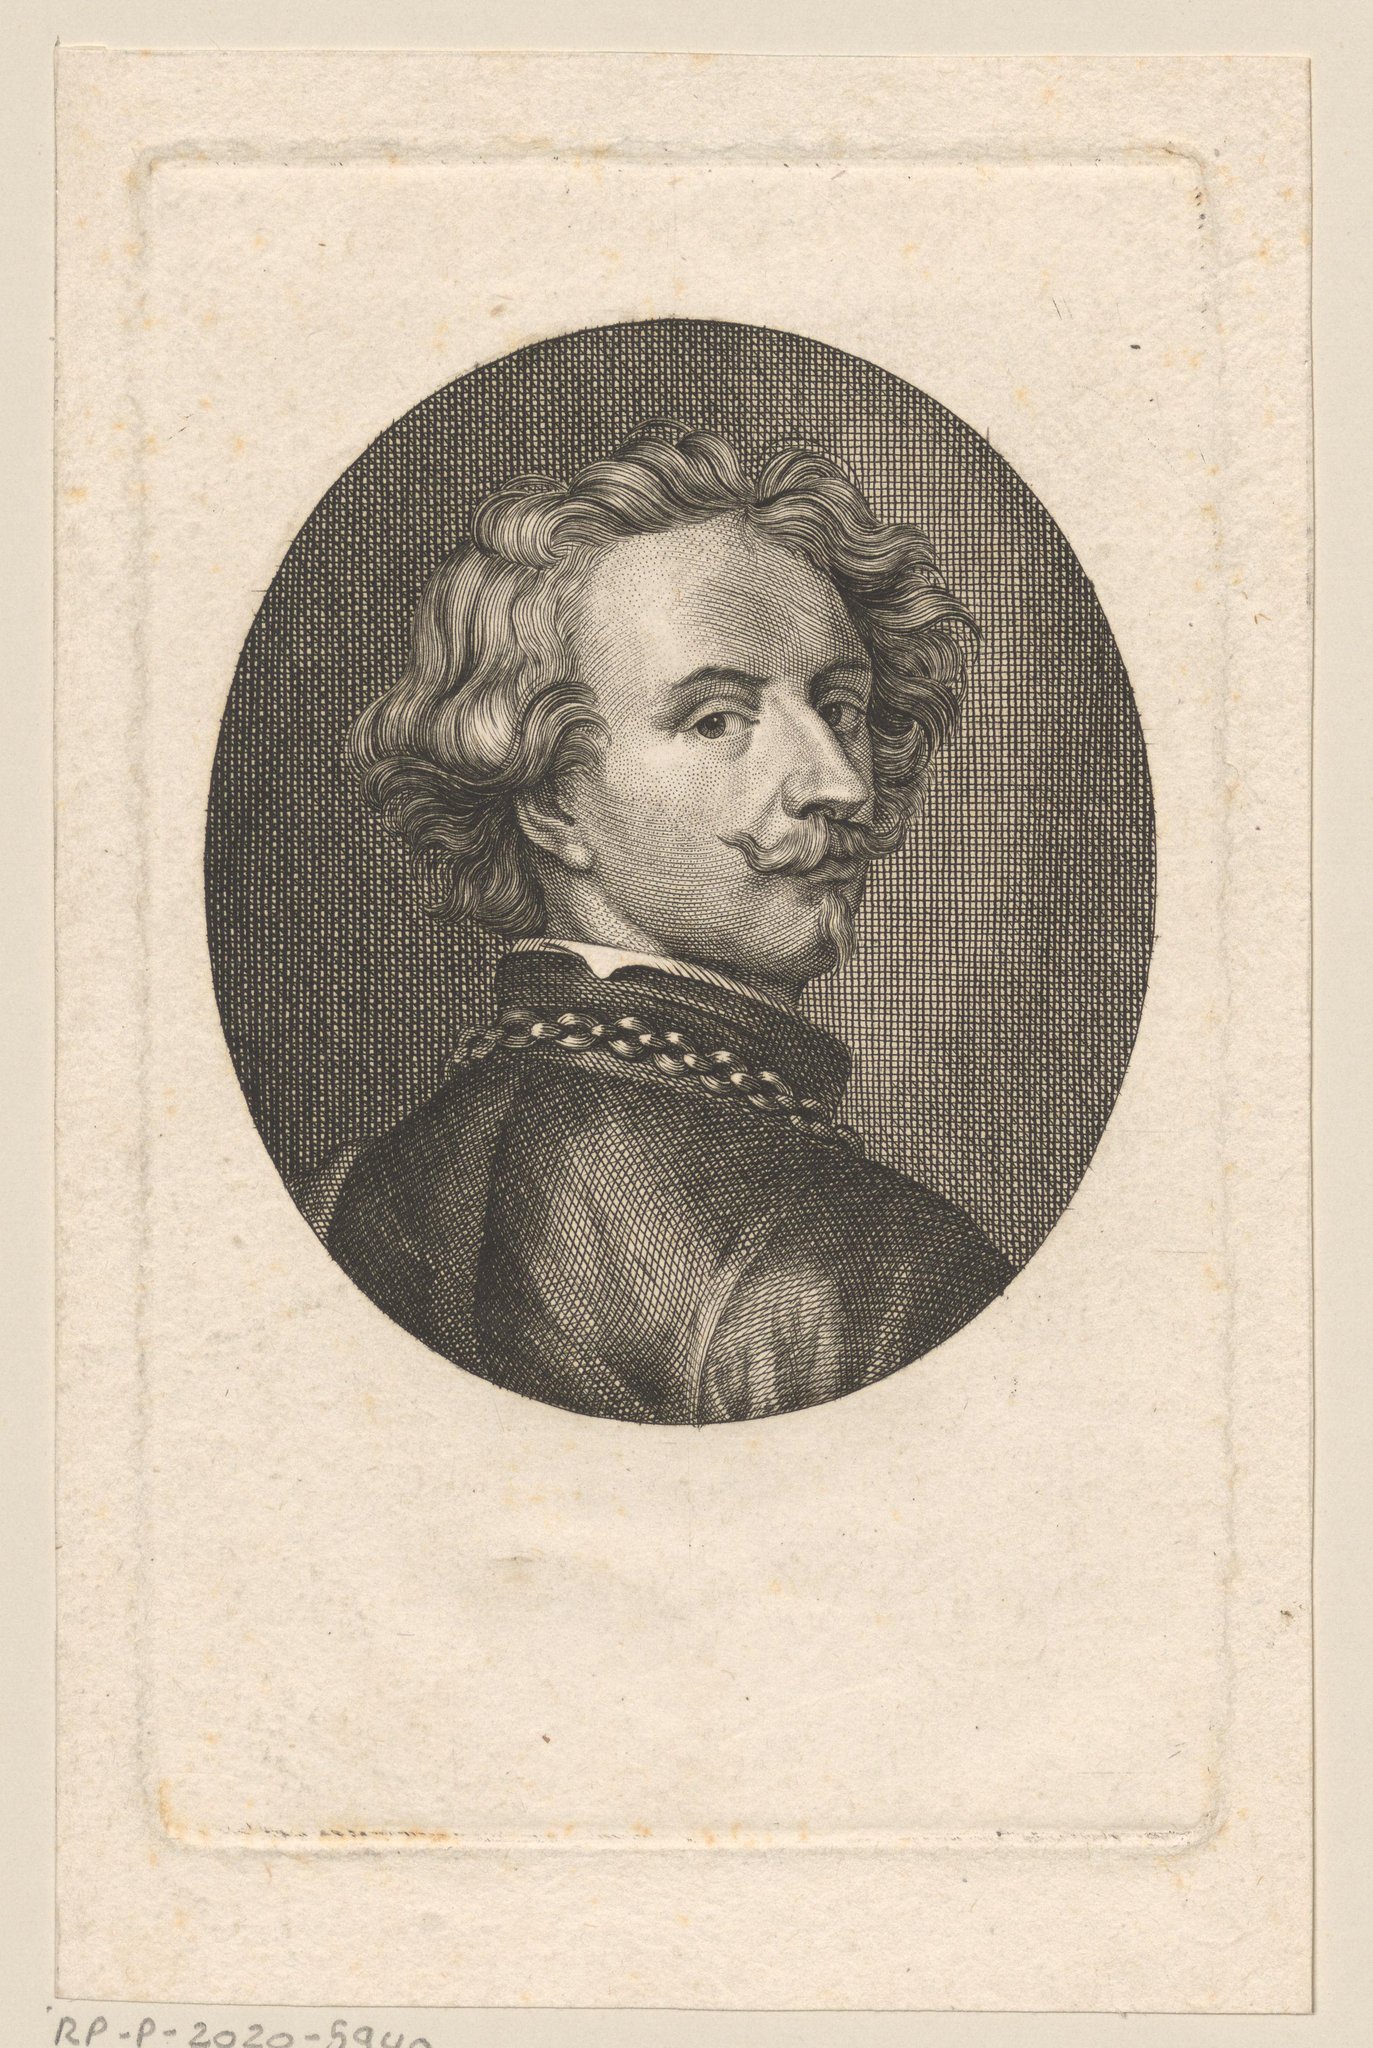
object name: print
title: Portret van Anthony van Dyck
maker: Anonymous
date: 1700-1799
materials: paper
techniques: engraving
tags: antwerp, london, painter, print maker, draughtsman, anthony van dyck, historical persons, portrait, self-portrait of painter